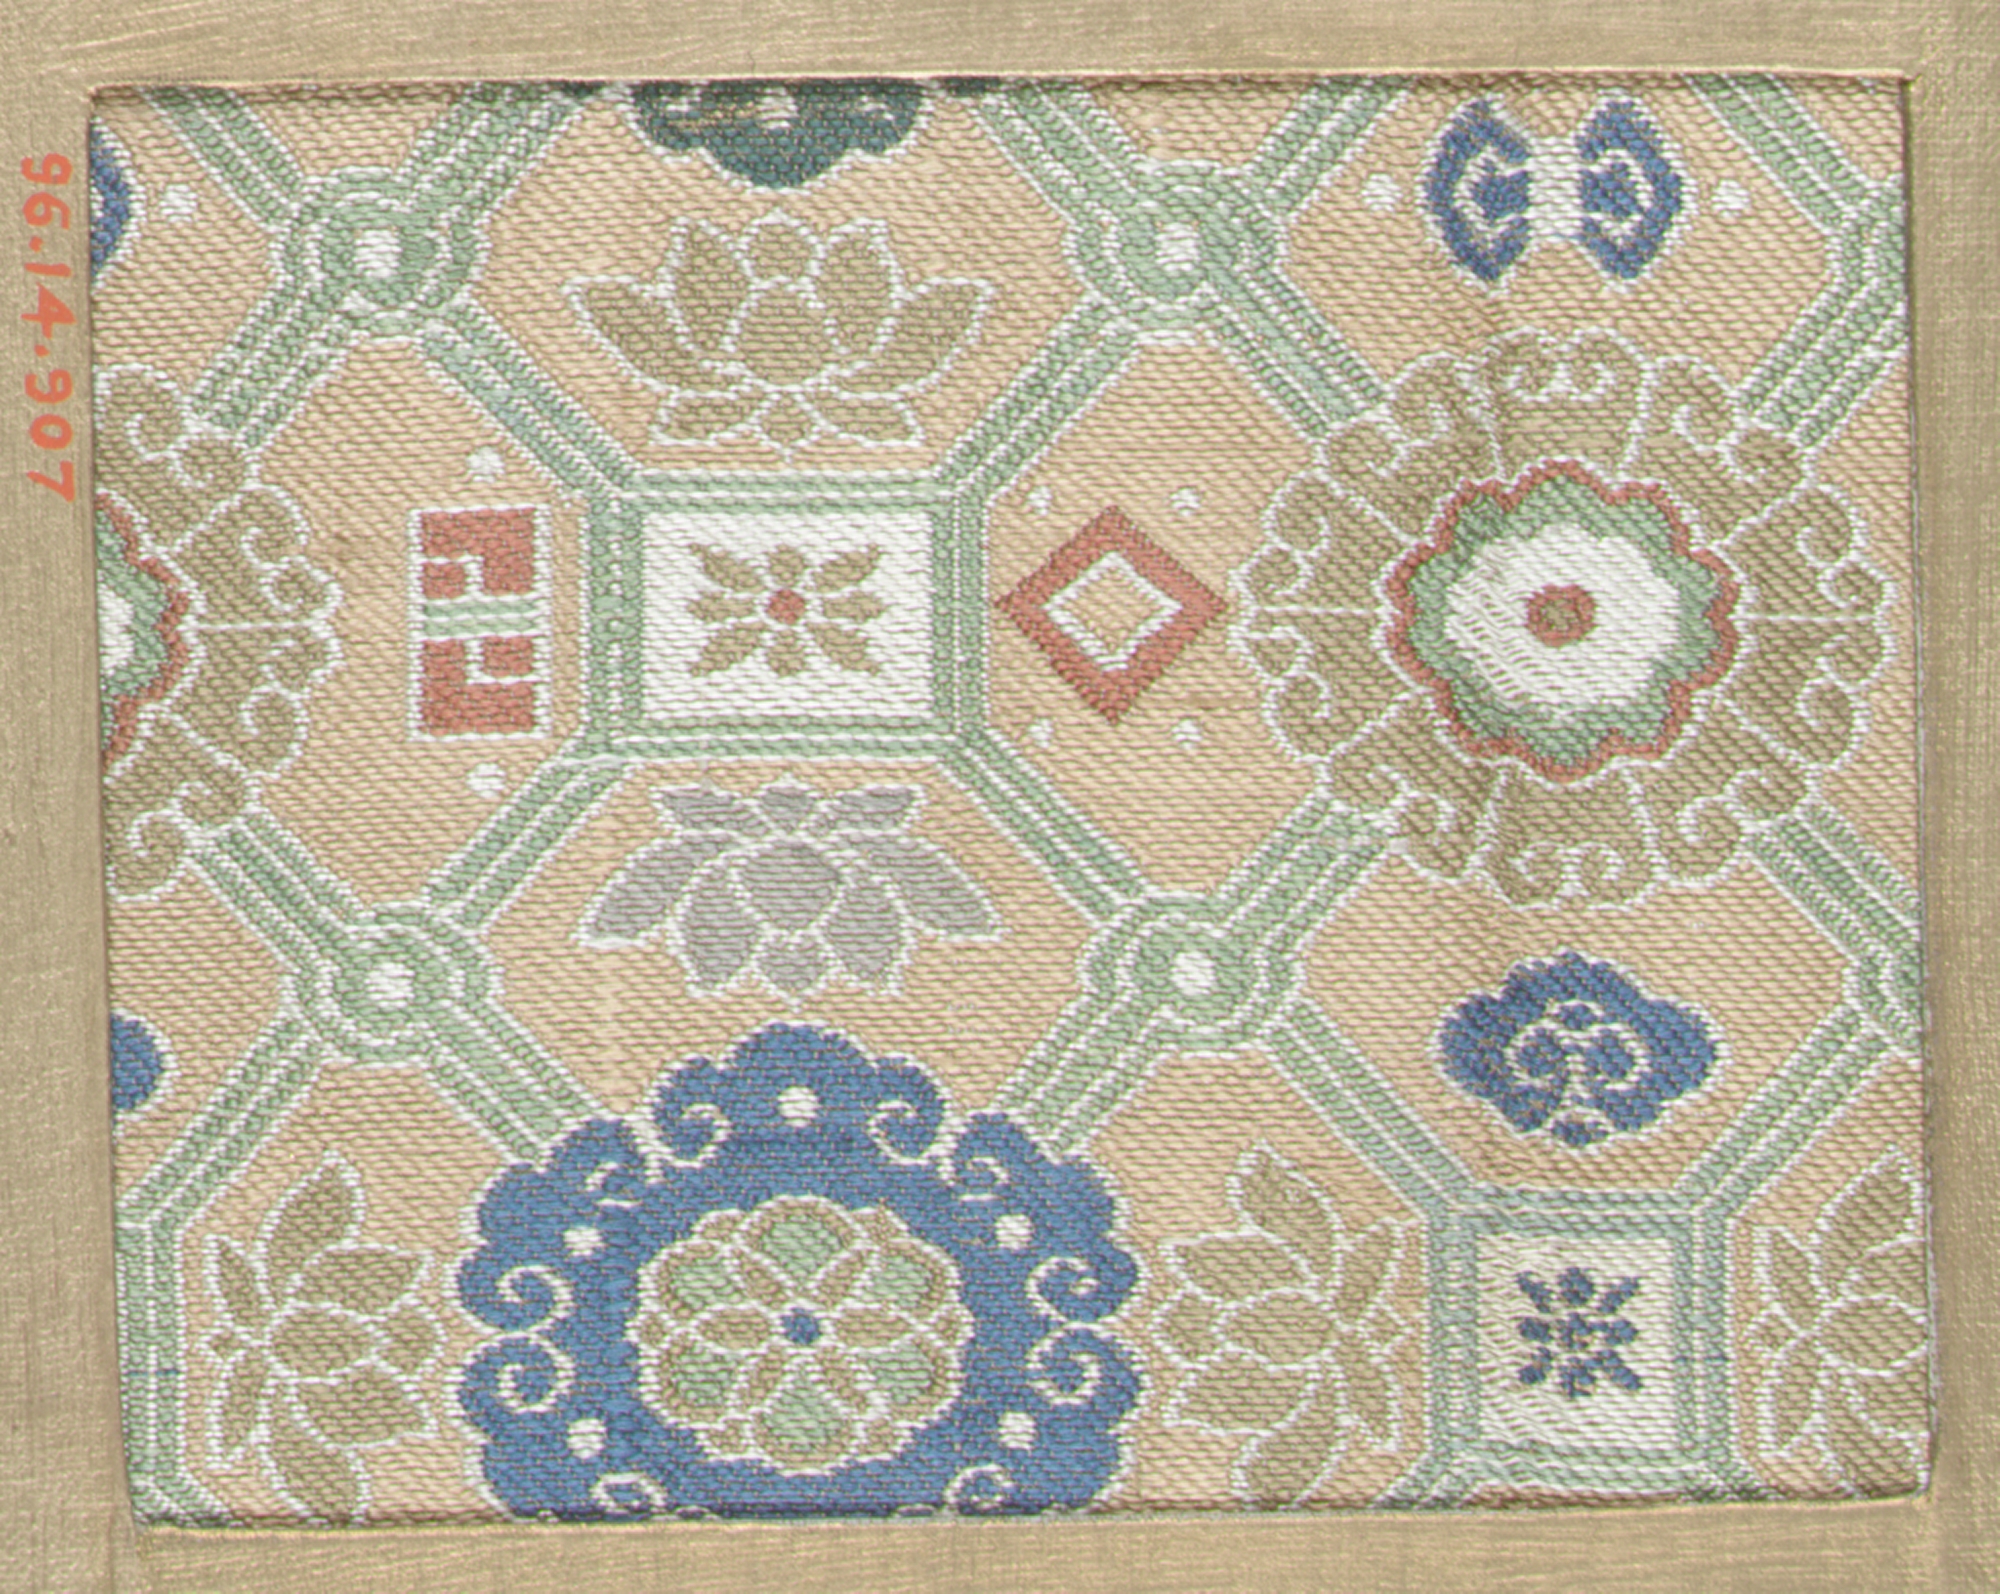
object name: piece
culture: japanese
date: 1701-1900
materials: silk